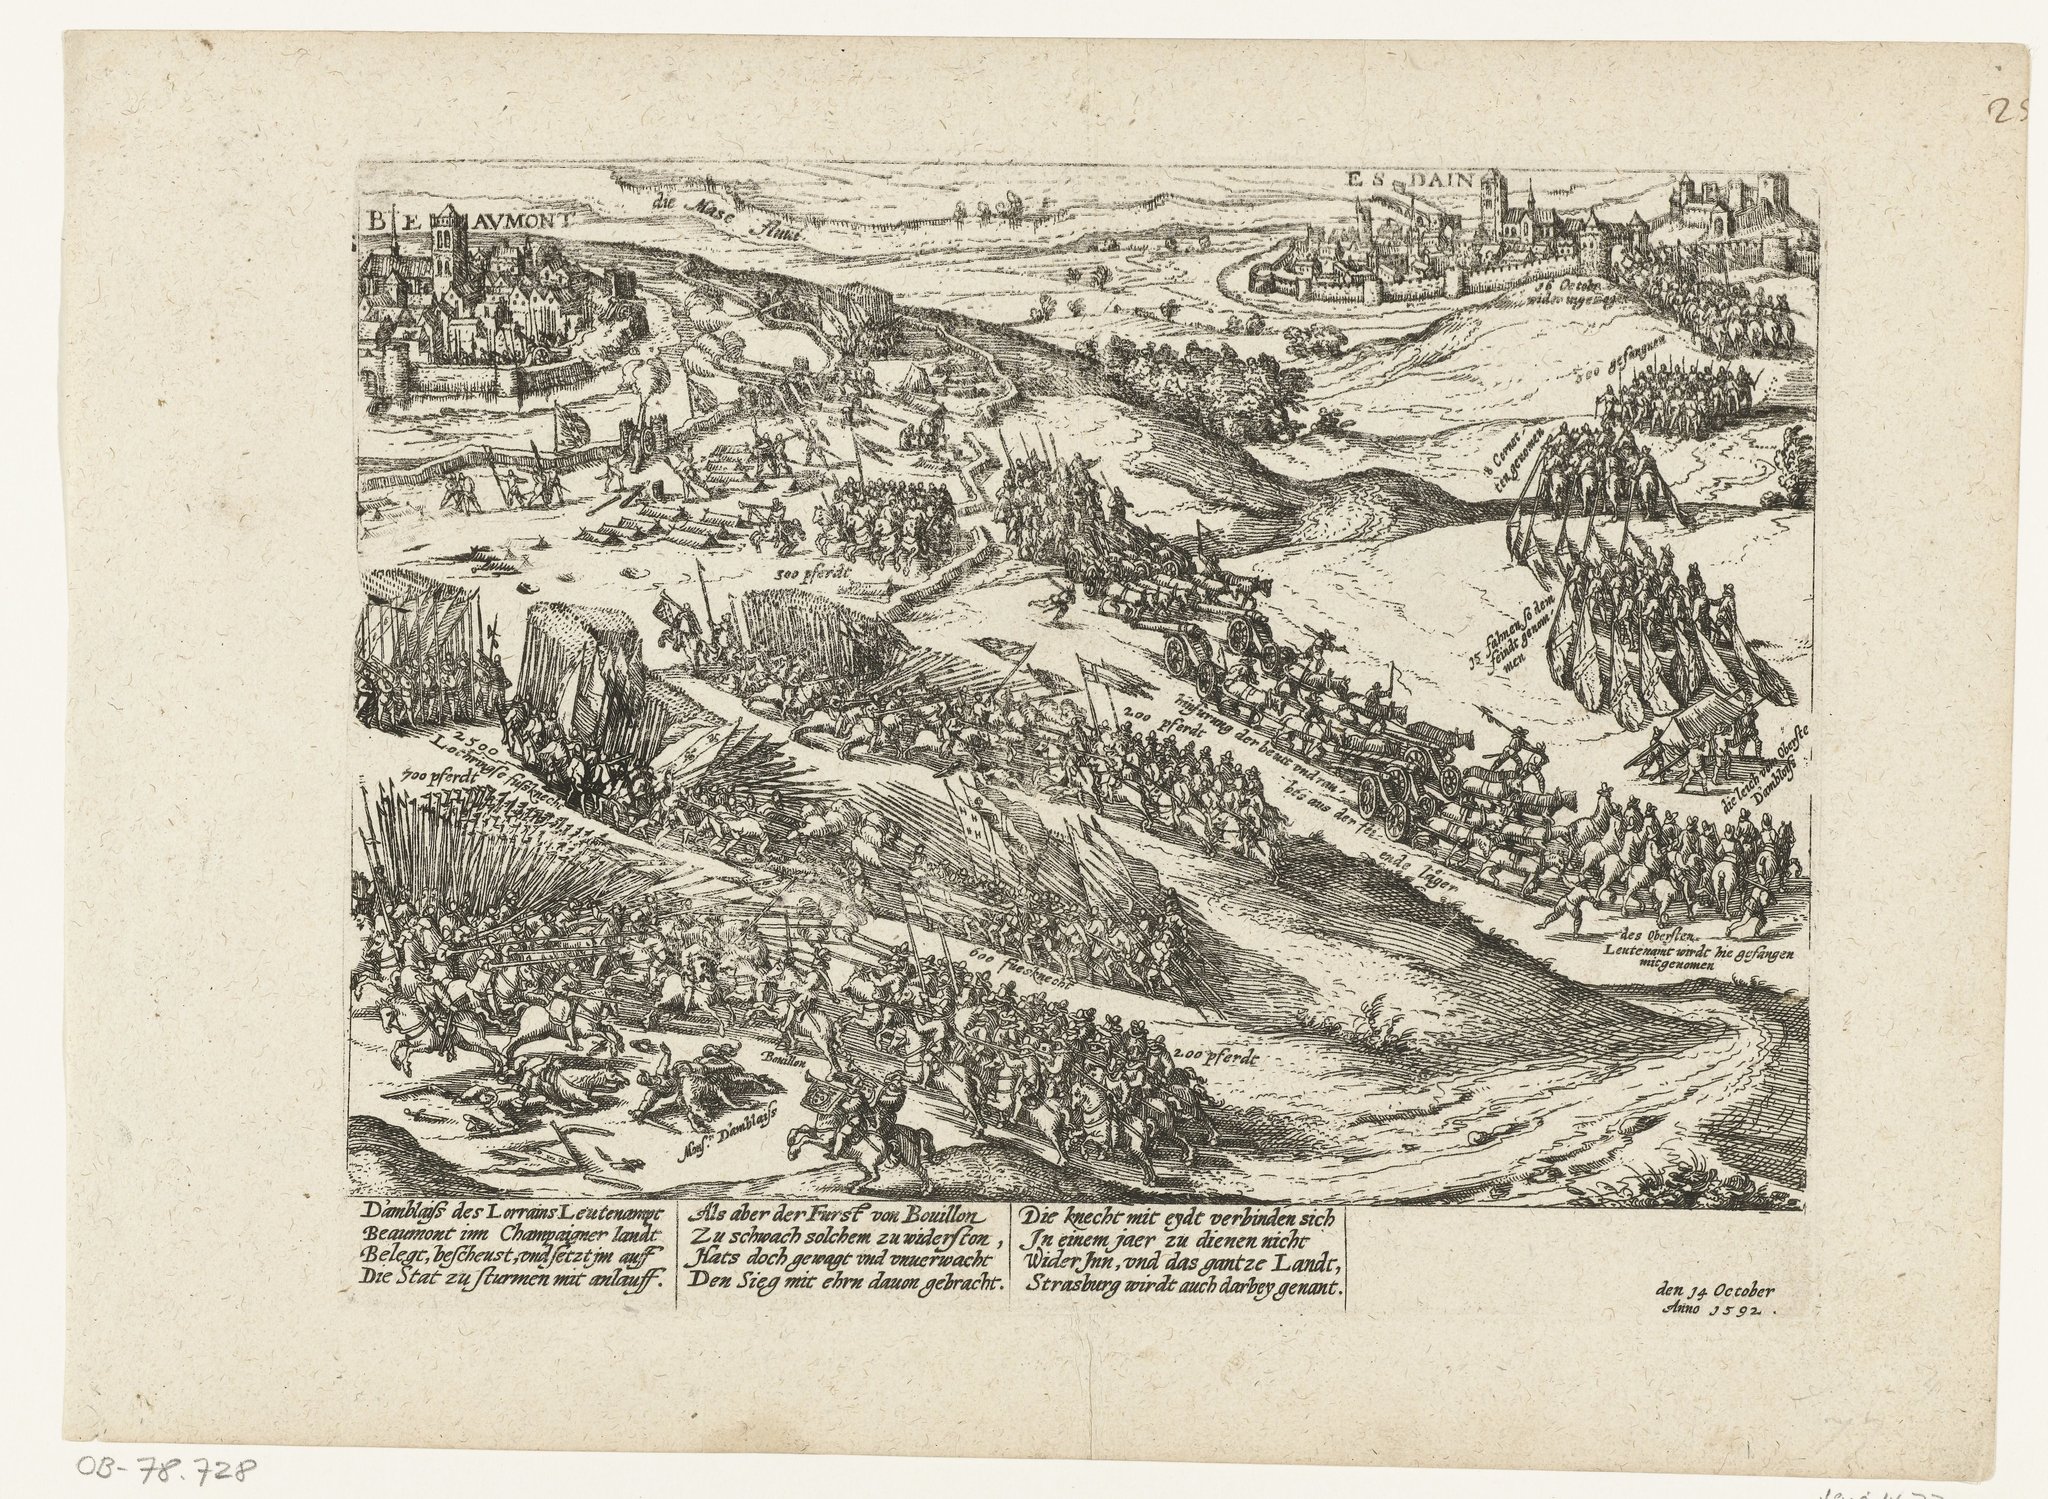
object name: print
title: Overwinning van Bouillon bij Beaumont, 1592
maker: frans hogenberg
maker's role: print maker, publisher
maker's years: 1538-1590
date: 1592-1594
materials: paper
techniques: etching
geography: cologne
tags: battle, fighting in general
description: Overwinning van Bouillon op de legers van de hertog van Lotharingen bij Beaumont in Henegouwen, 14 oktober 1592. Met onderschrift van 12 regels in het Duits. Ongenummerd. Blad afkomstig uit een album dat uit elkaar is gehaald. Rechtsboven genummerd (in pen): 25(.).